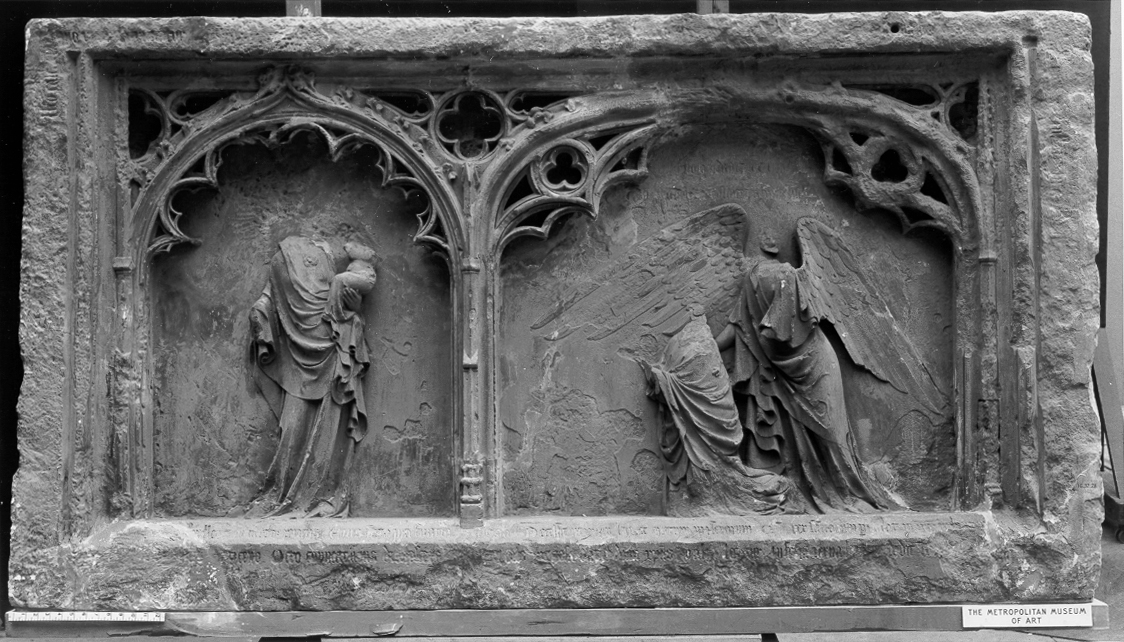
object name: relief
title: Funerary Relief from the Tomb of Milon de Donzy (d. 1337-38), dean of the Cathedral of Nevers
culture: french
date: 1301-1400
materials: limestone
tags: angels,madonna and child